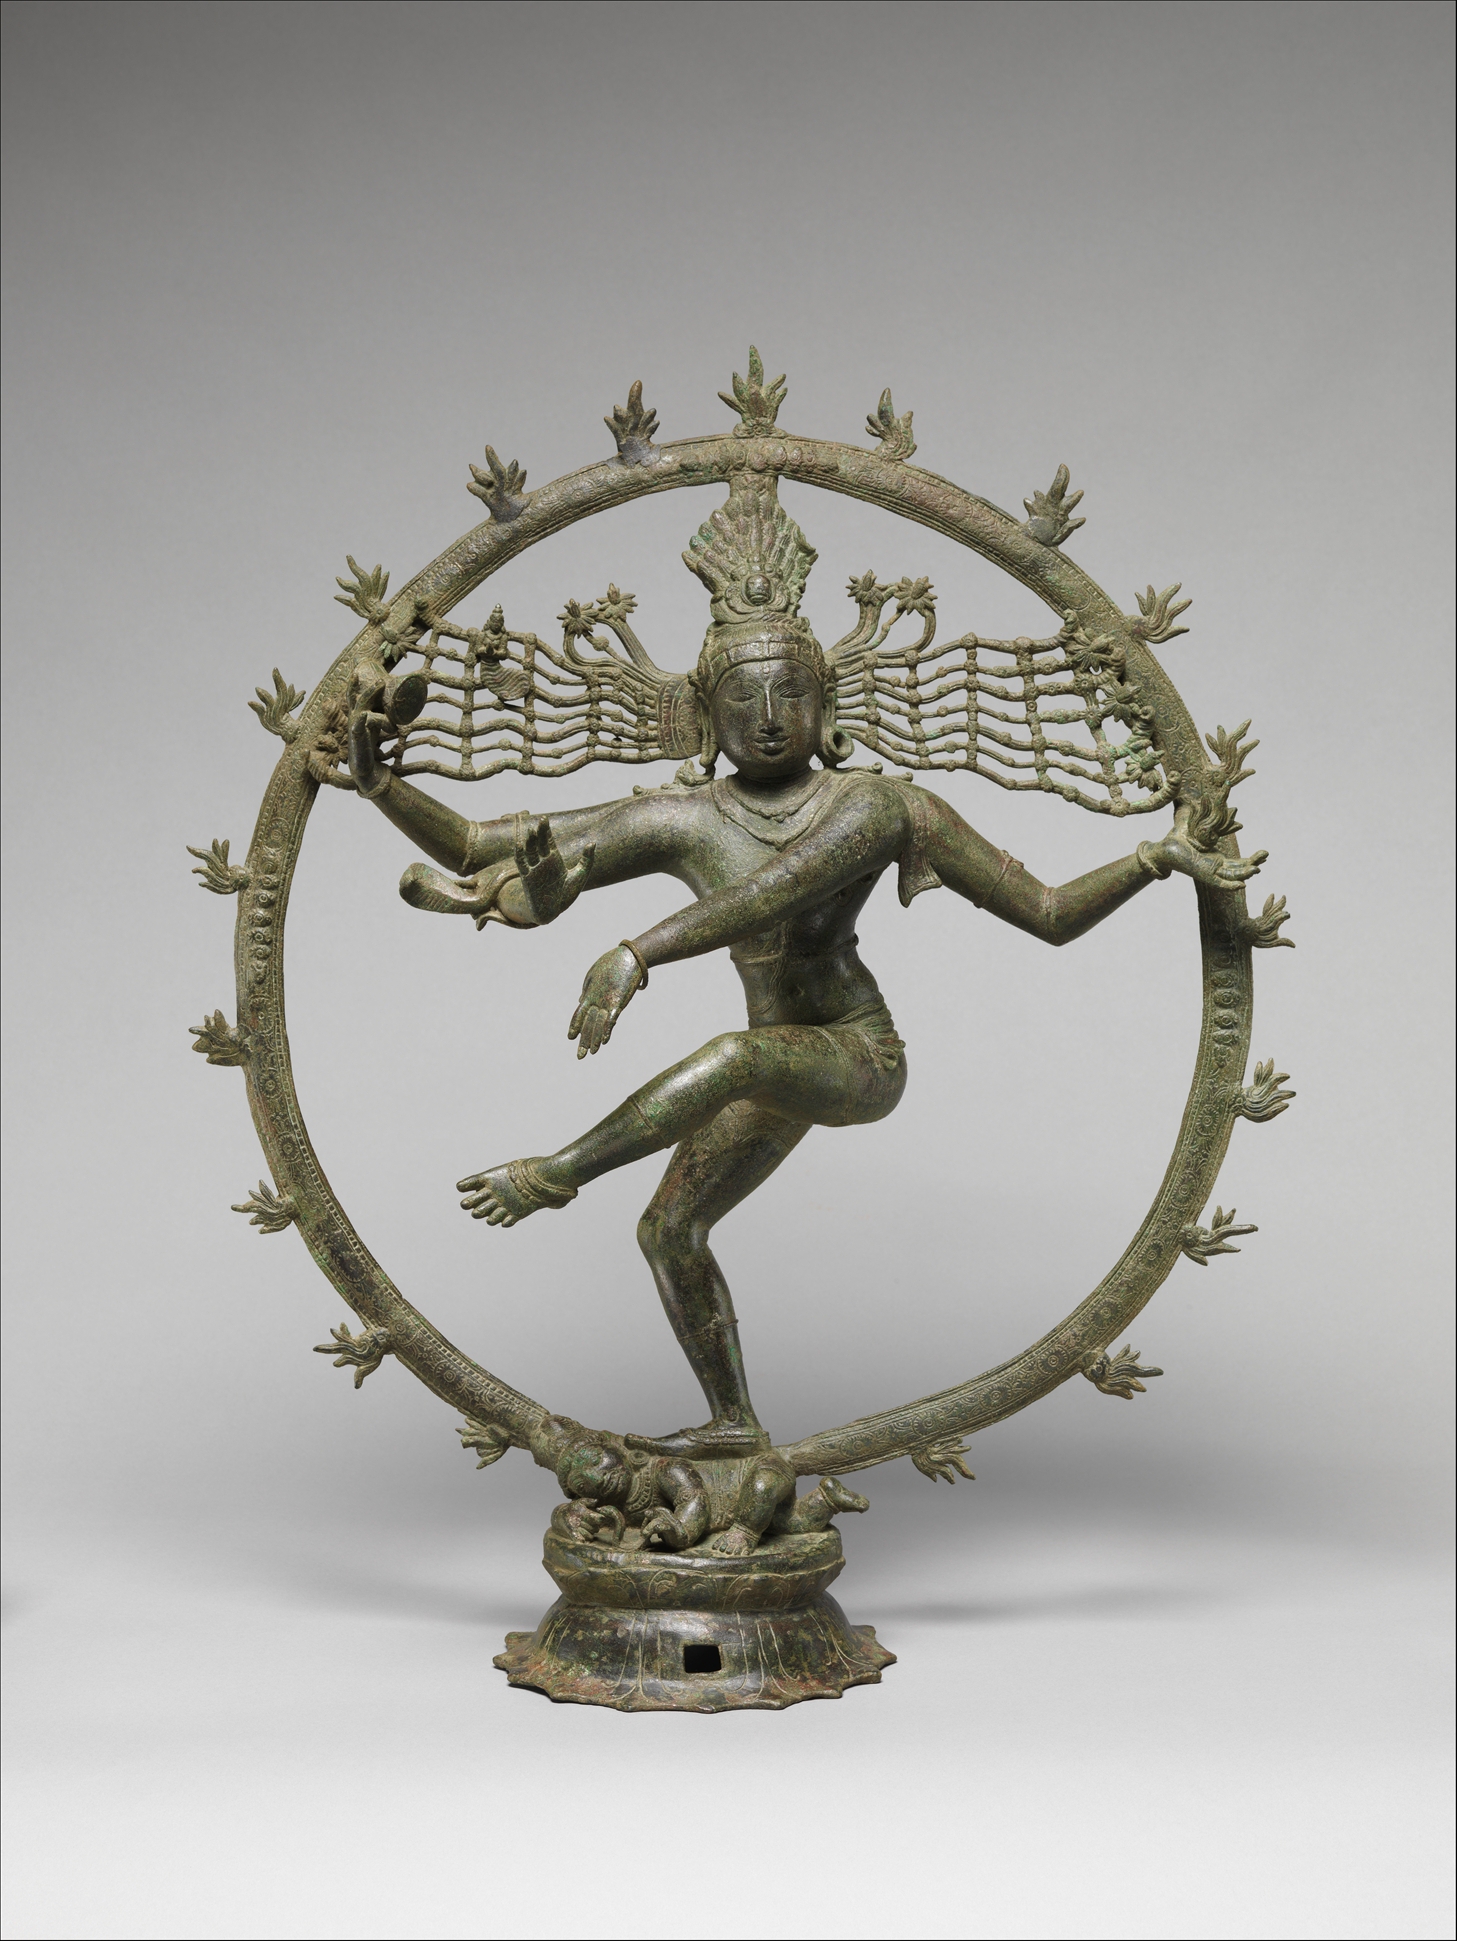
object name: figure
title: Shiva as Lord of Dance (Shiva Nataraja)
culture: tamil nadu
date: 1167-1233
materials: copper alloy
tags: shiva,hinduism